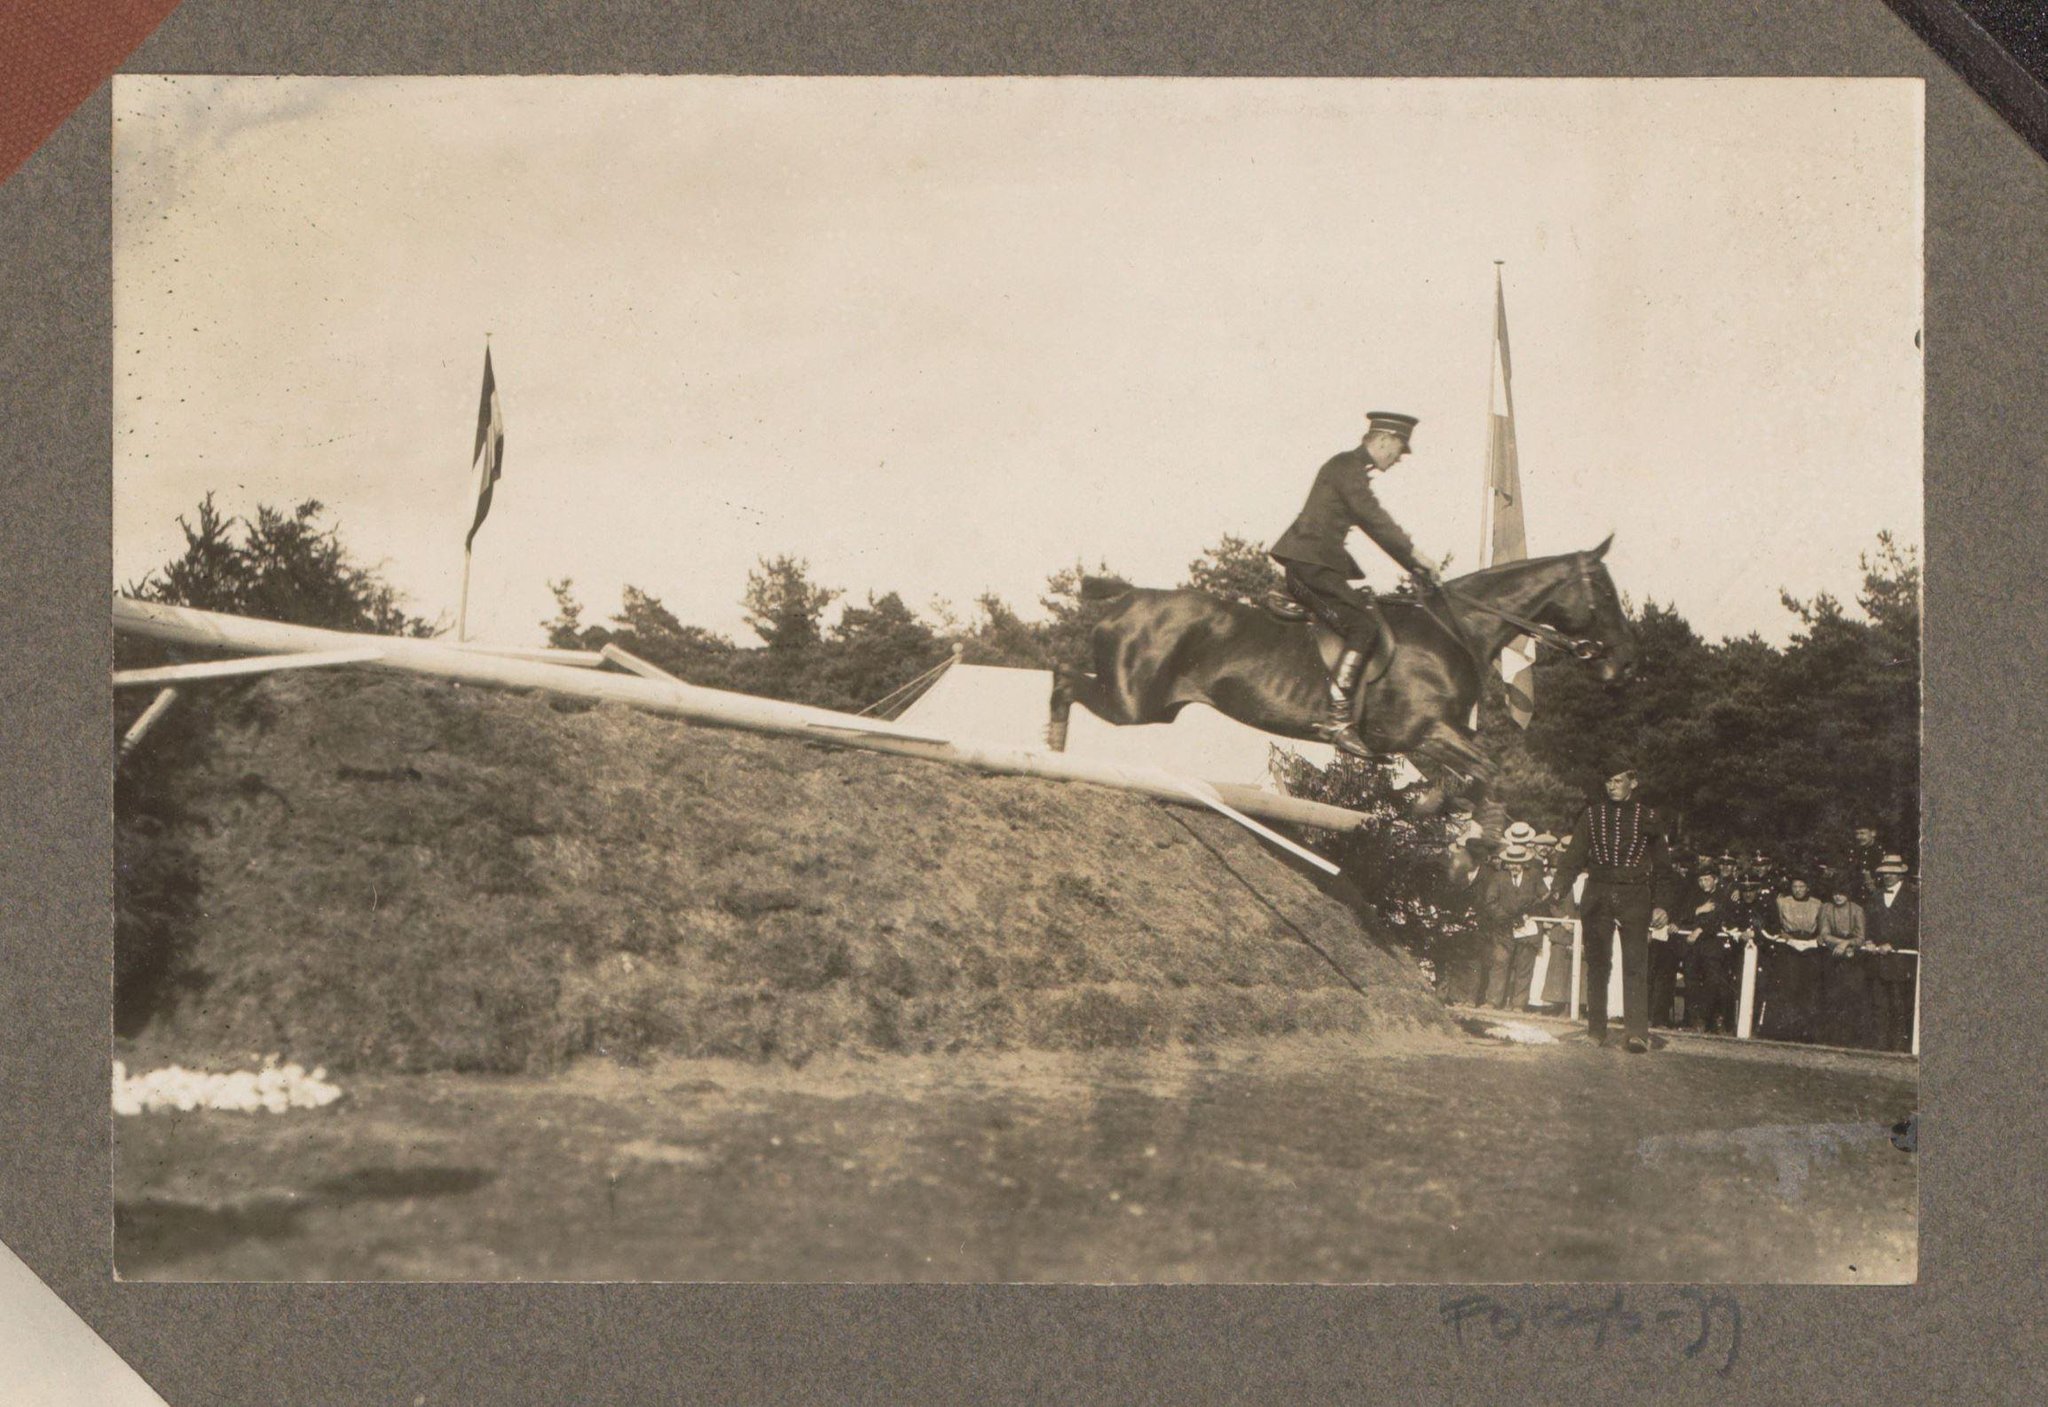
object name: photograph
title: Ruitertafereel op Koninklijke Houtvesterij Het Loo: geüniformeerde ruiter neemt hindernis op een renbaan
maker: Anonymous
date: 1900-1925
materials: photographic support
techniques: gelatin silver print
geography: het loo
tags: riding a horse, ass, or mule; rider, horseman, hunting, chase, hunting-ground, horse-racing, jumping (horse in motion), (military) uniforms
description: Onderdeel van Fotoalbum van de heer Brams, opperhoutvester van koningin Wilhelmina op Koninklijke Houtvesterij Het Loo.